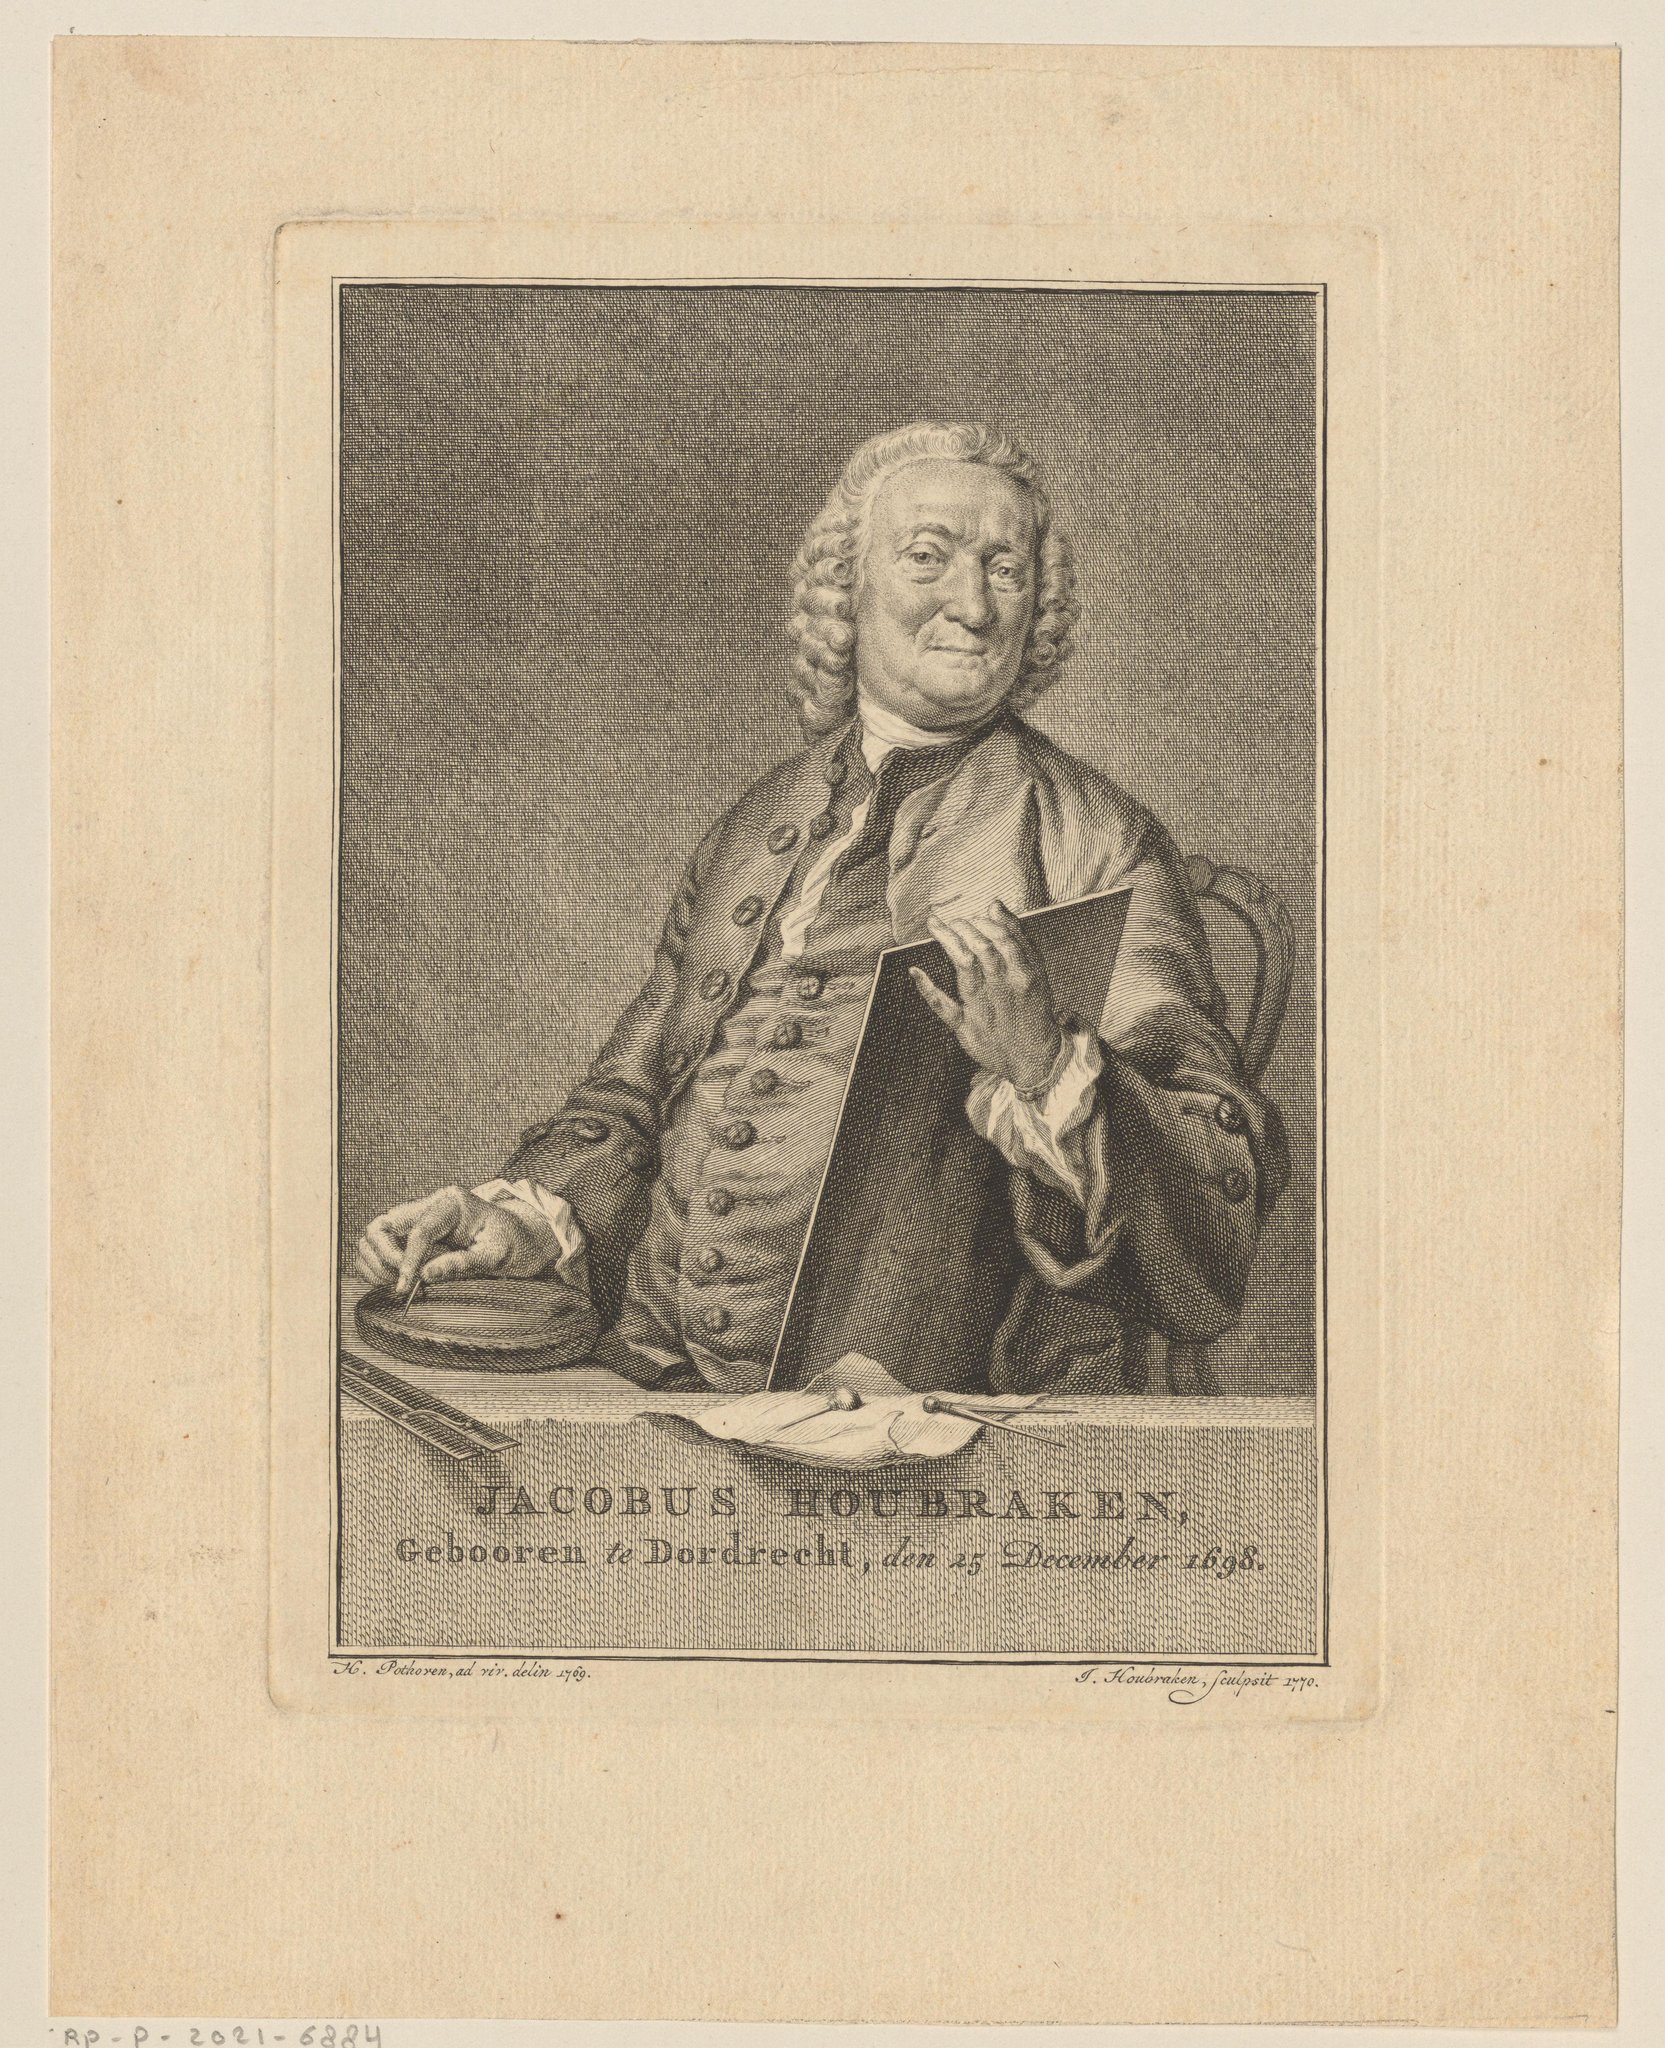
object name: print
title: Portret van Jacob Houbraken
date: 1770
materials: paper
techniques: engraving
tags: dordrecht, amsterdam, print maker, draughtsman, jacob houbraken, portrait, self-portrait of sculptor, historical persons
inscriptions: collector's mark: Lugt 963, inscription: ‘door de Hr Gootman(?)’